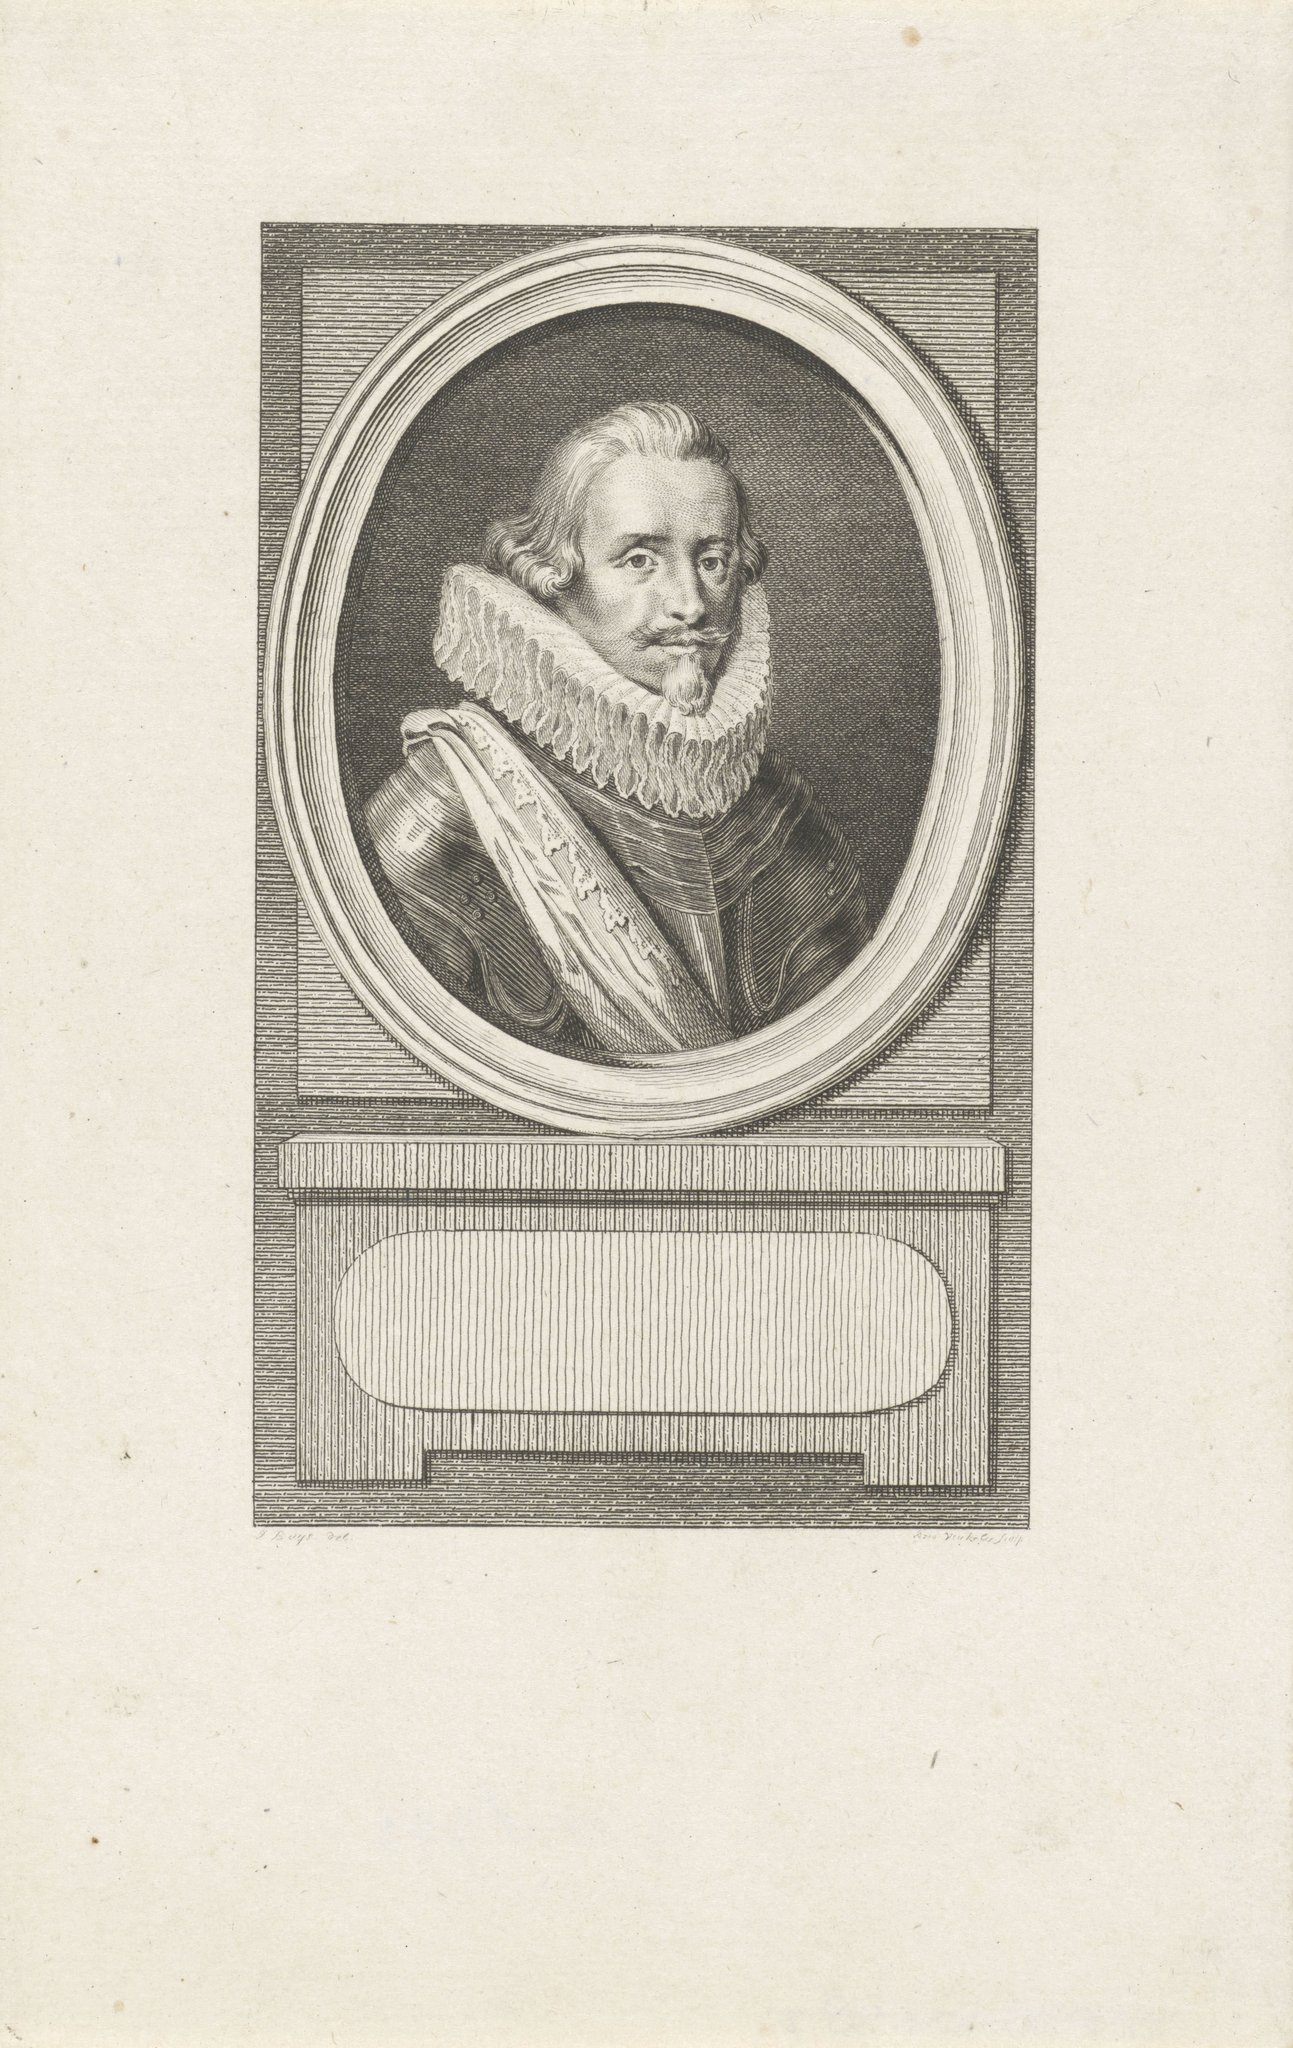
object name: print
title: Portret van Ernst Casimir, graaf van Nassau-Dietz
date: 1785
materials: paper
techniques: engraving, etching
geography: amsterdam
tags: ernst casimir graaf van nassau-dietz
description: De hier vermelde titel verwijst naar de hoogst verkregen titel van de geportretteerde, niet per se naar de titel die de geportretteerde op deze voorstelling draagt.